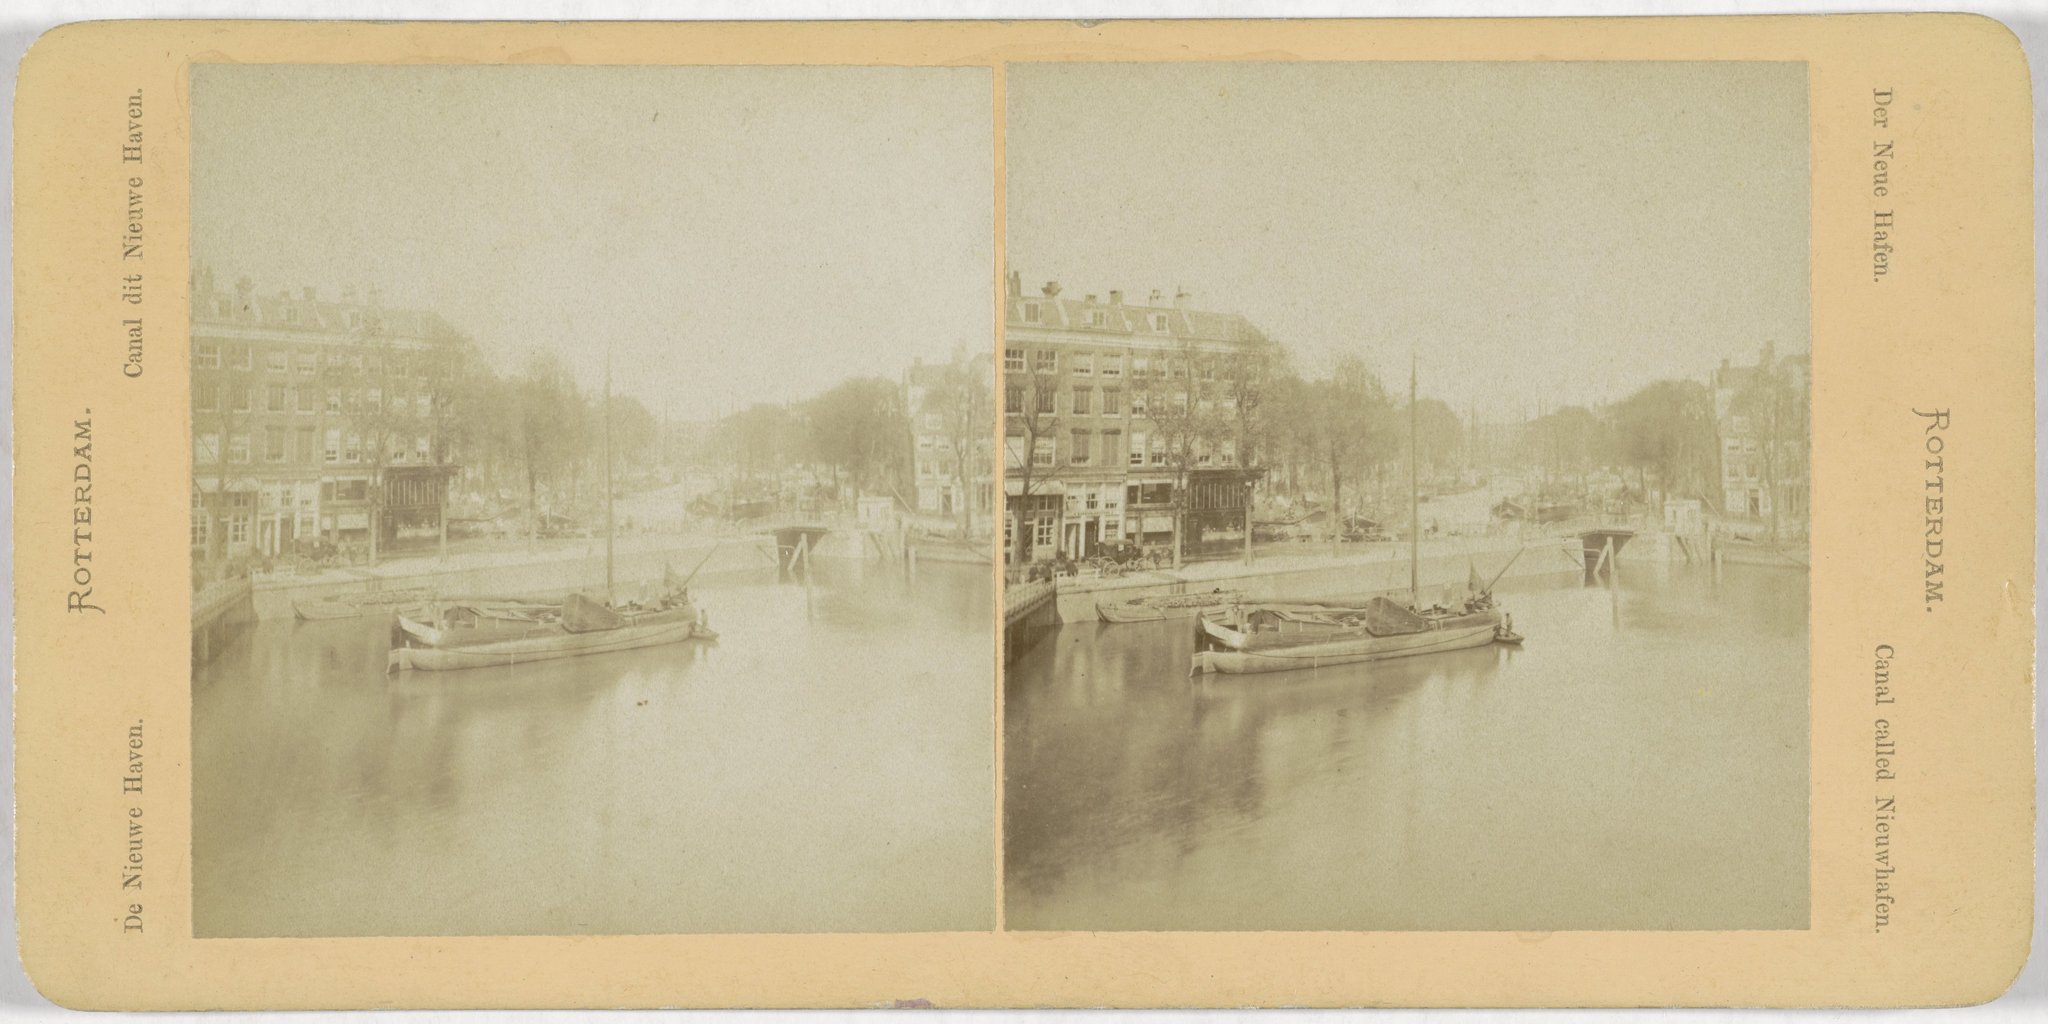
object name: stereograph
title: Rotterdam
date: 1873-1890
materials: cardboard, paper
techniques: albumen print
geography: amsterdam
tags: harbour